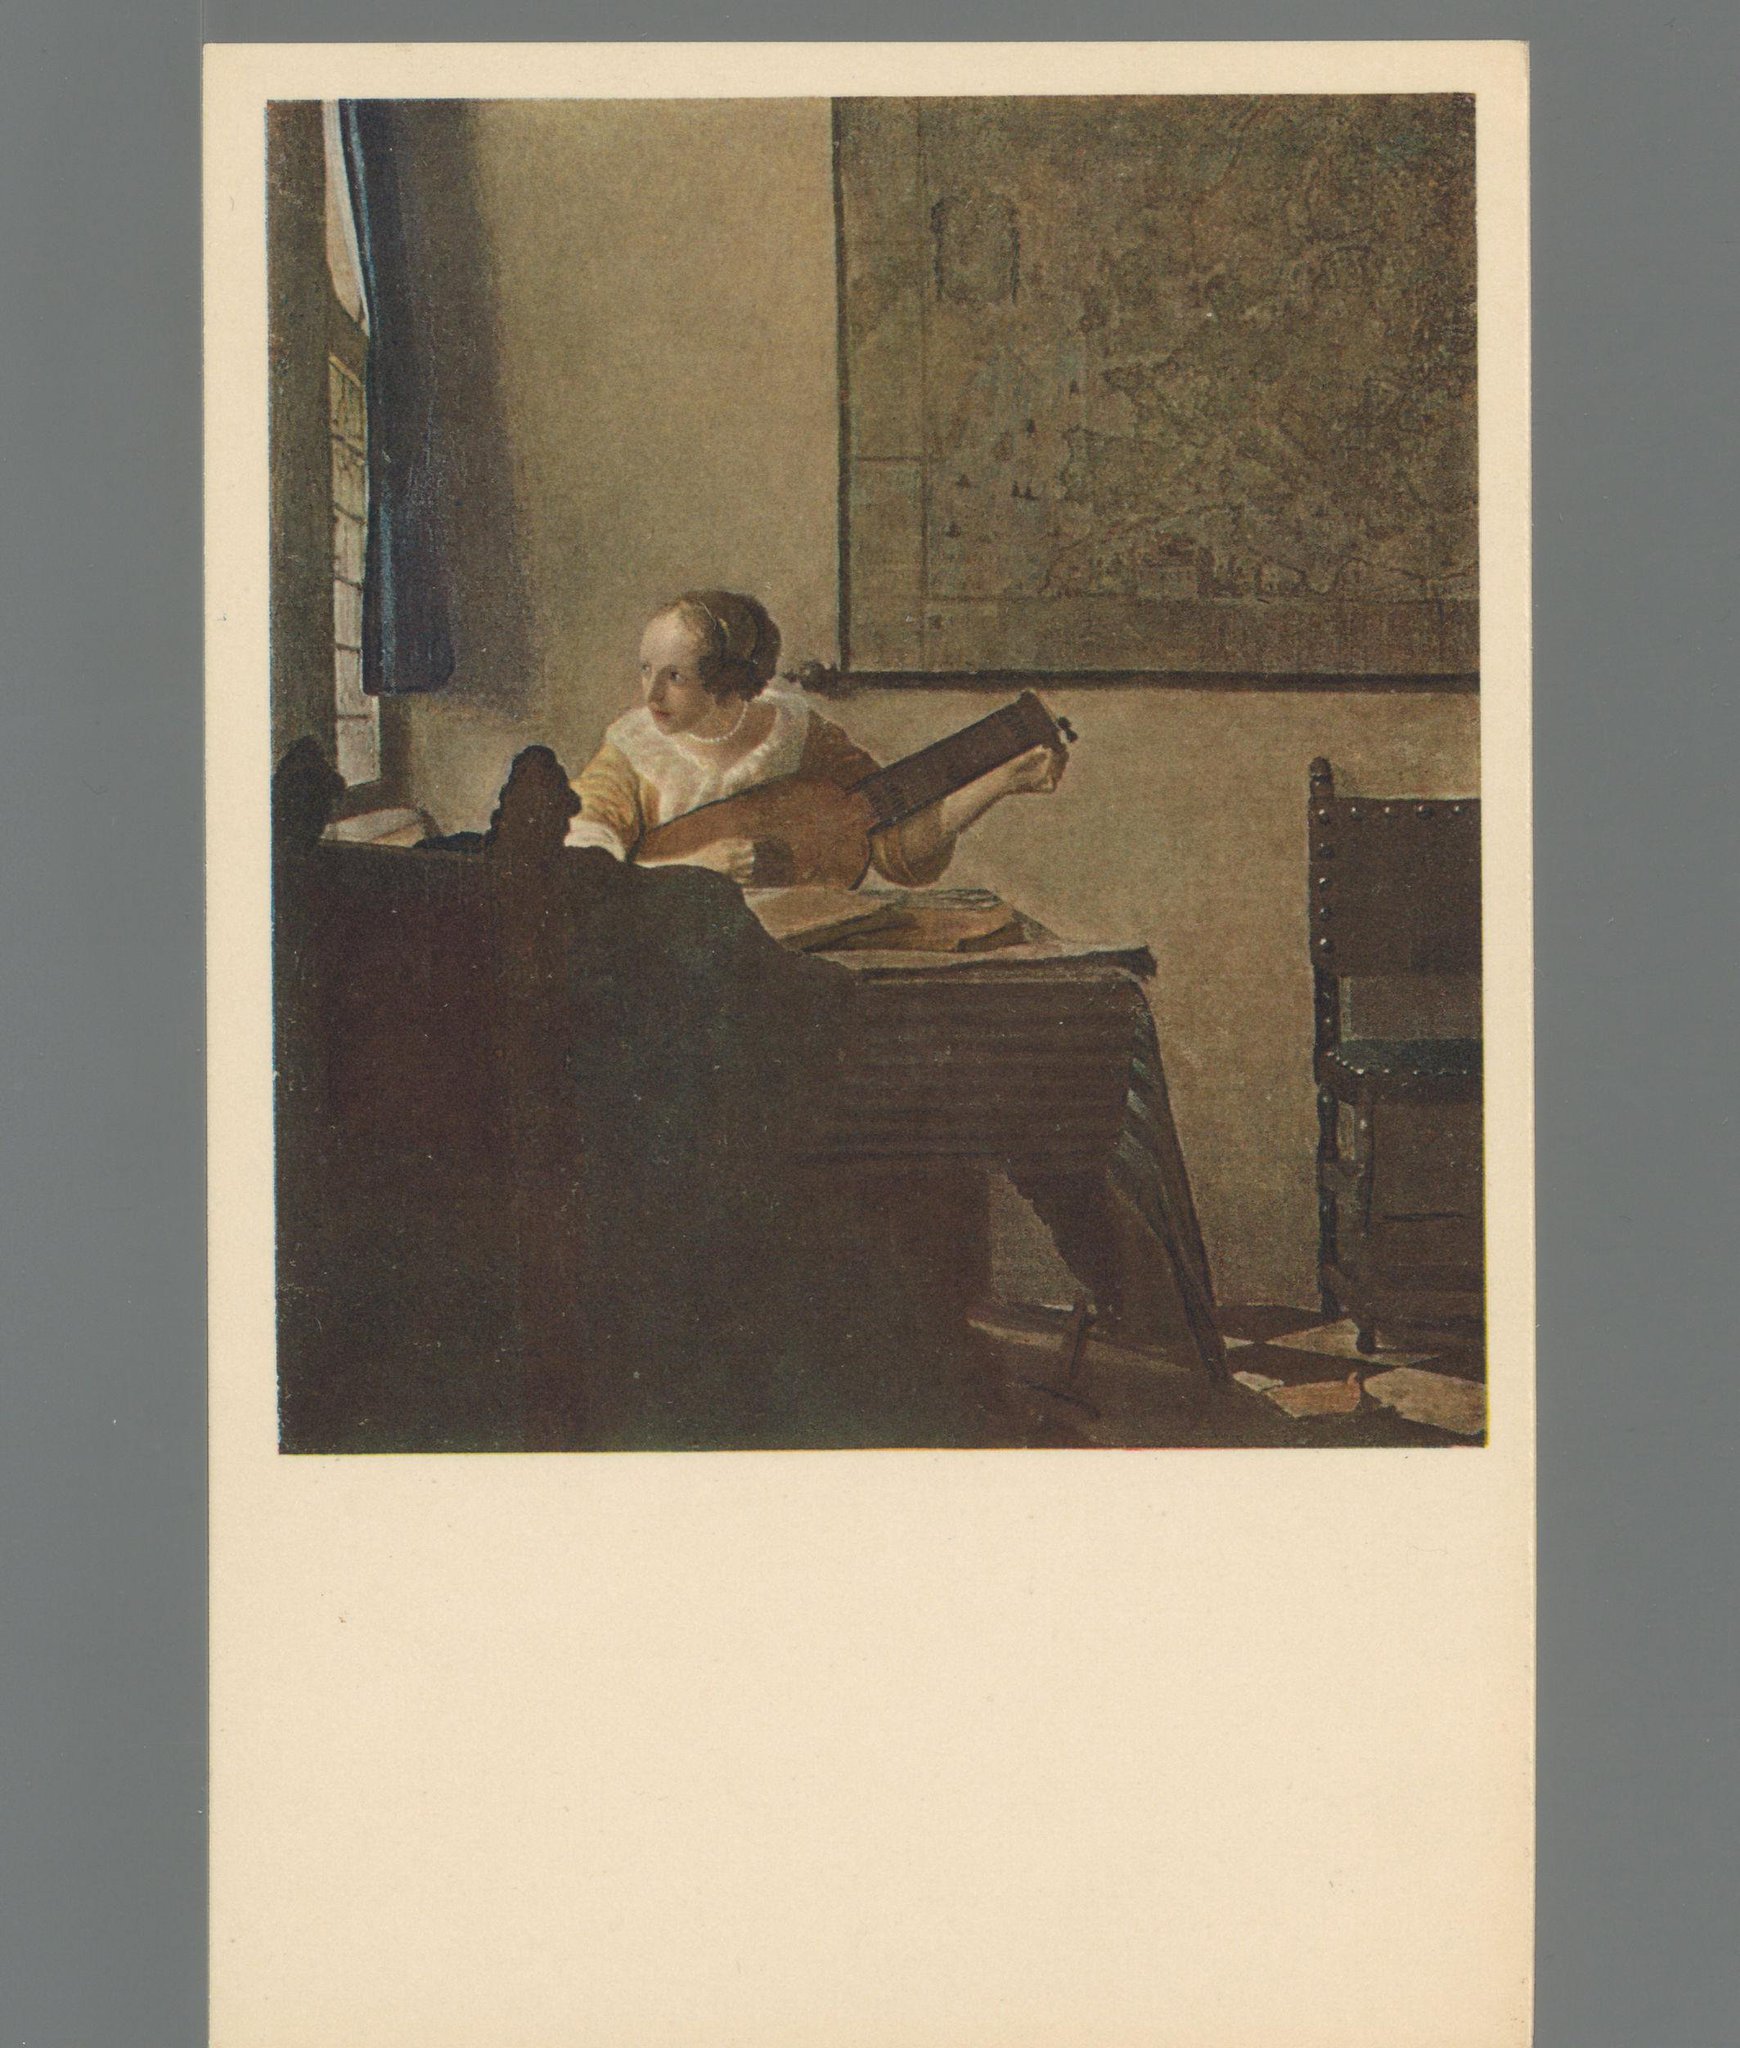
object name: reproduction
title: Lady with a Lute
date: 1925-1940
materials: cardboard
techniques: photograph, lithograph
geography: new york city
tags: adult woman, maps of separate countries or regions, lute, and special forms of lute, e.g.: theorbo (+ artist at work)